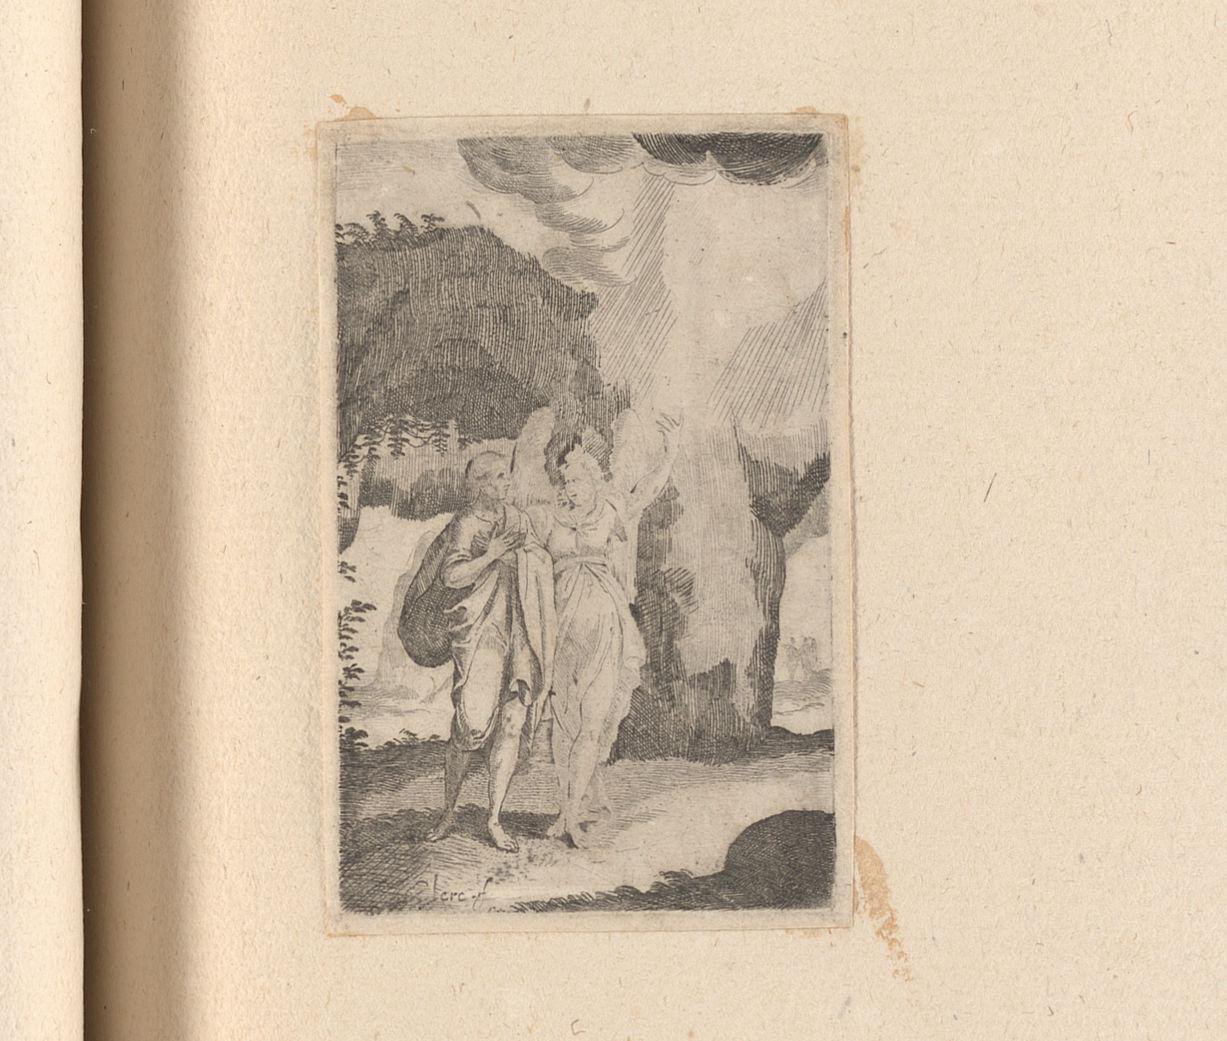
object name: print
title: Man met beschermengel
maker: sébastien leclerc (i)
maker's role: print maker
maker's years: 1637-1714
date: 1655-1683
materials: paper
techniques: etching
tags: guardian angel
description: Maakt deel uit van een negendelige serie.